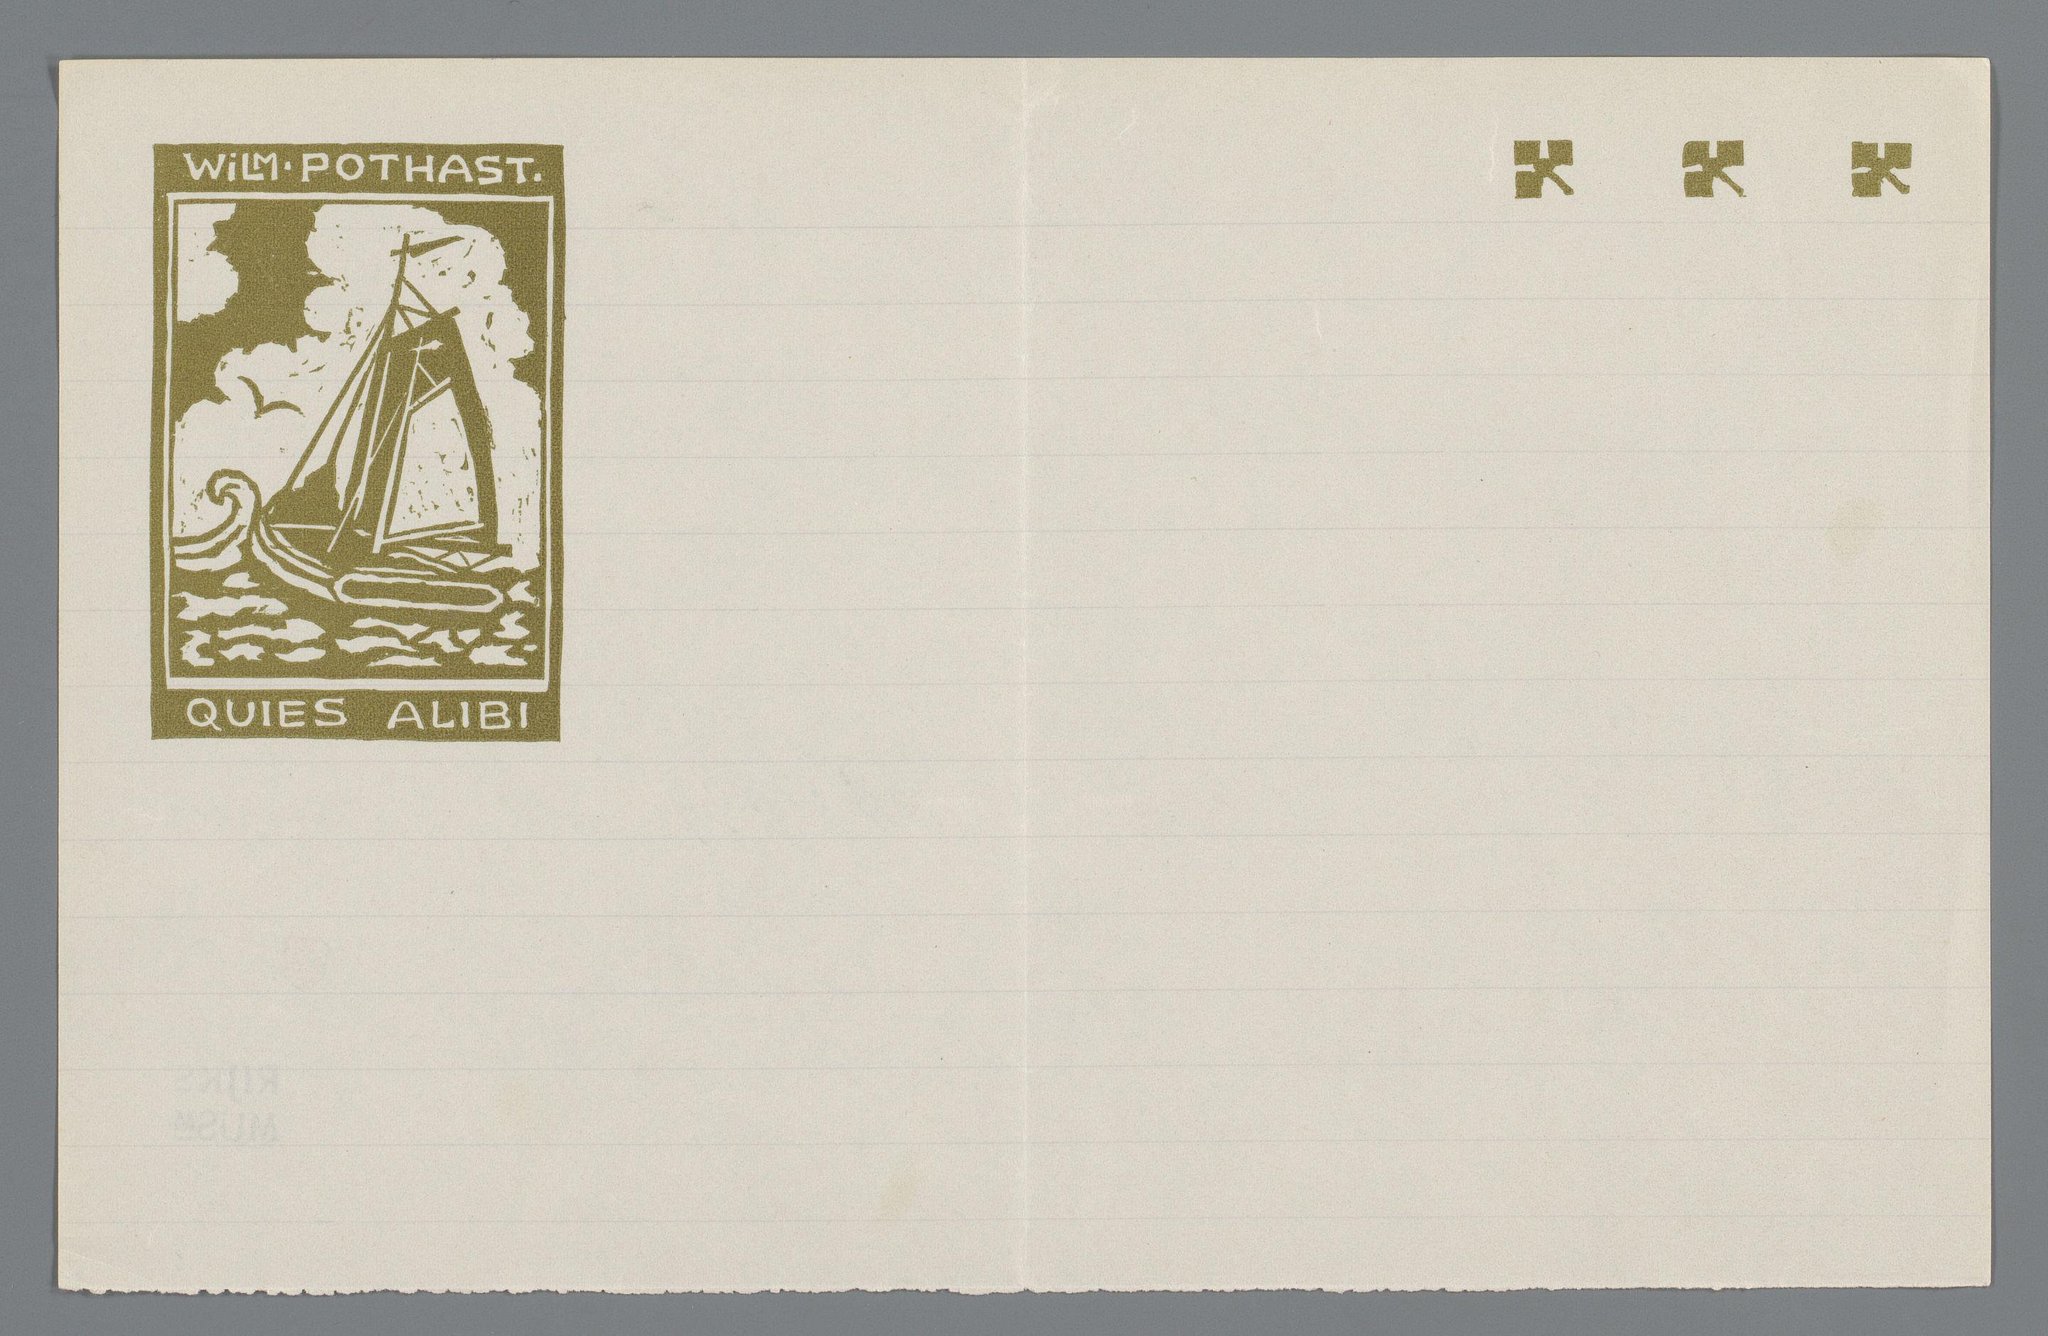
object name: print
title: Briefpapier met ex libris van Willem Pothast: zeilschip op het water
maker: willem pothast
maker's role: draughtsman, print maker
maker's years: 1877-1916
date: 1887-1916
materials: paper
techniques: woodcut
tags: haarlem, print maker, draughtsman, willem pothast, sailing-ship, sailing-boat, ex-libris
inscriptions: collector's mark: Lugt 2760, collector's mark: Lugt 2165